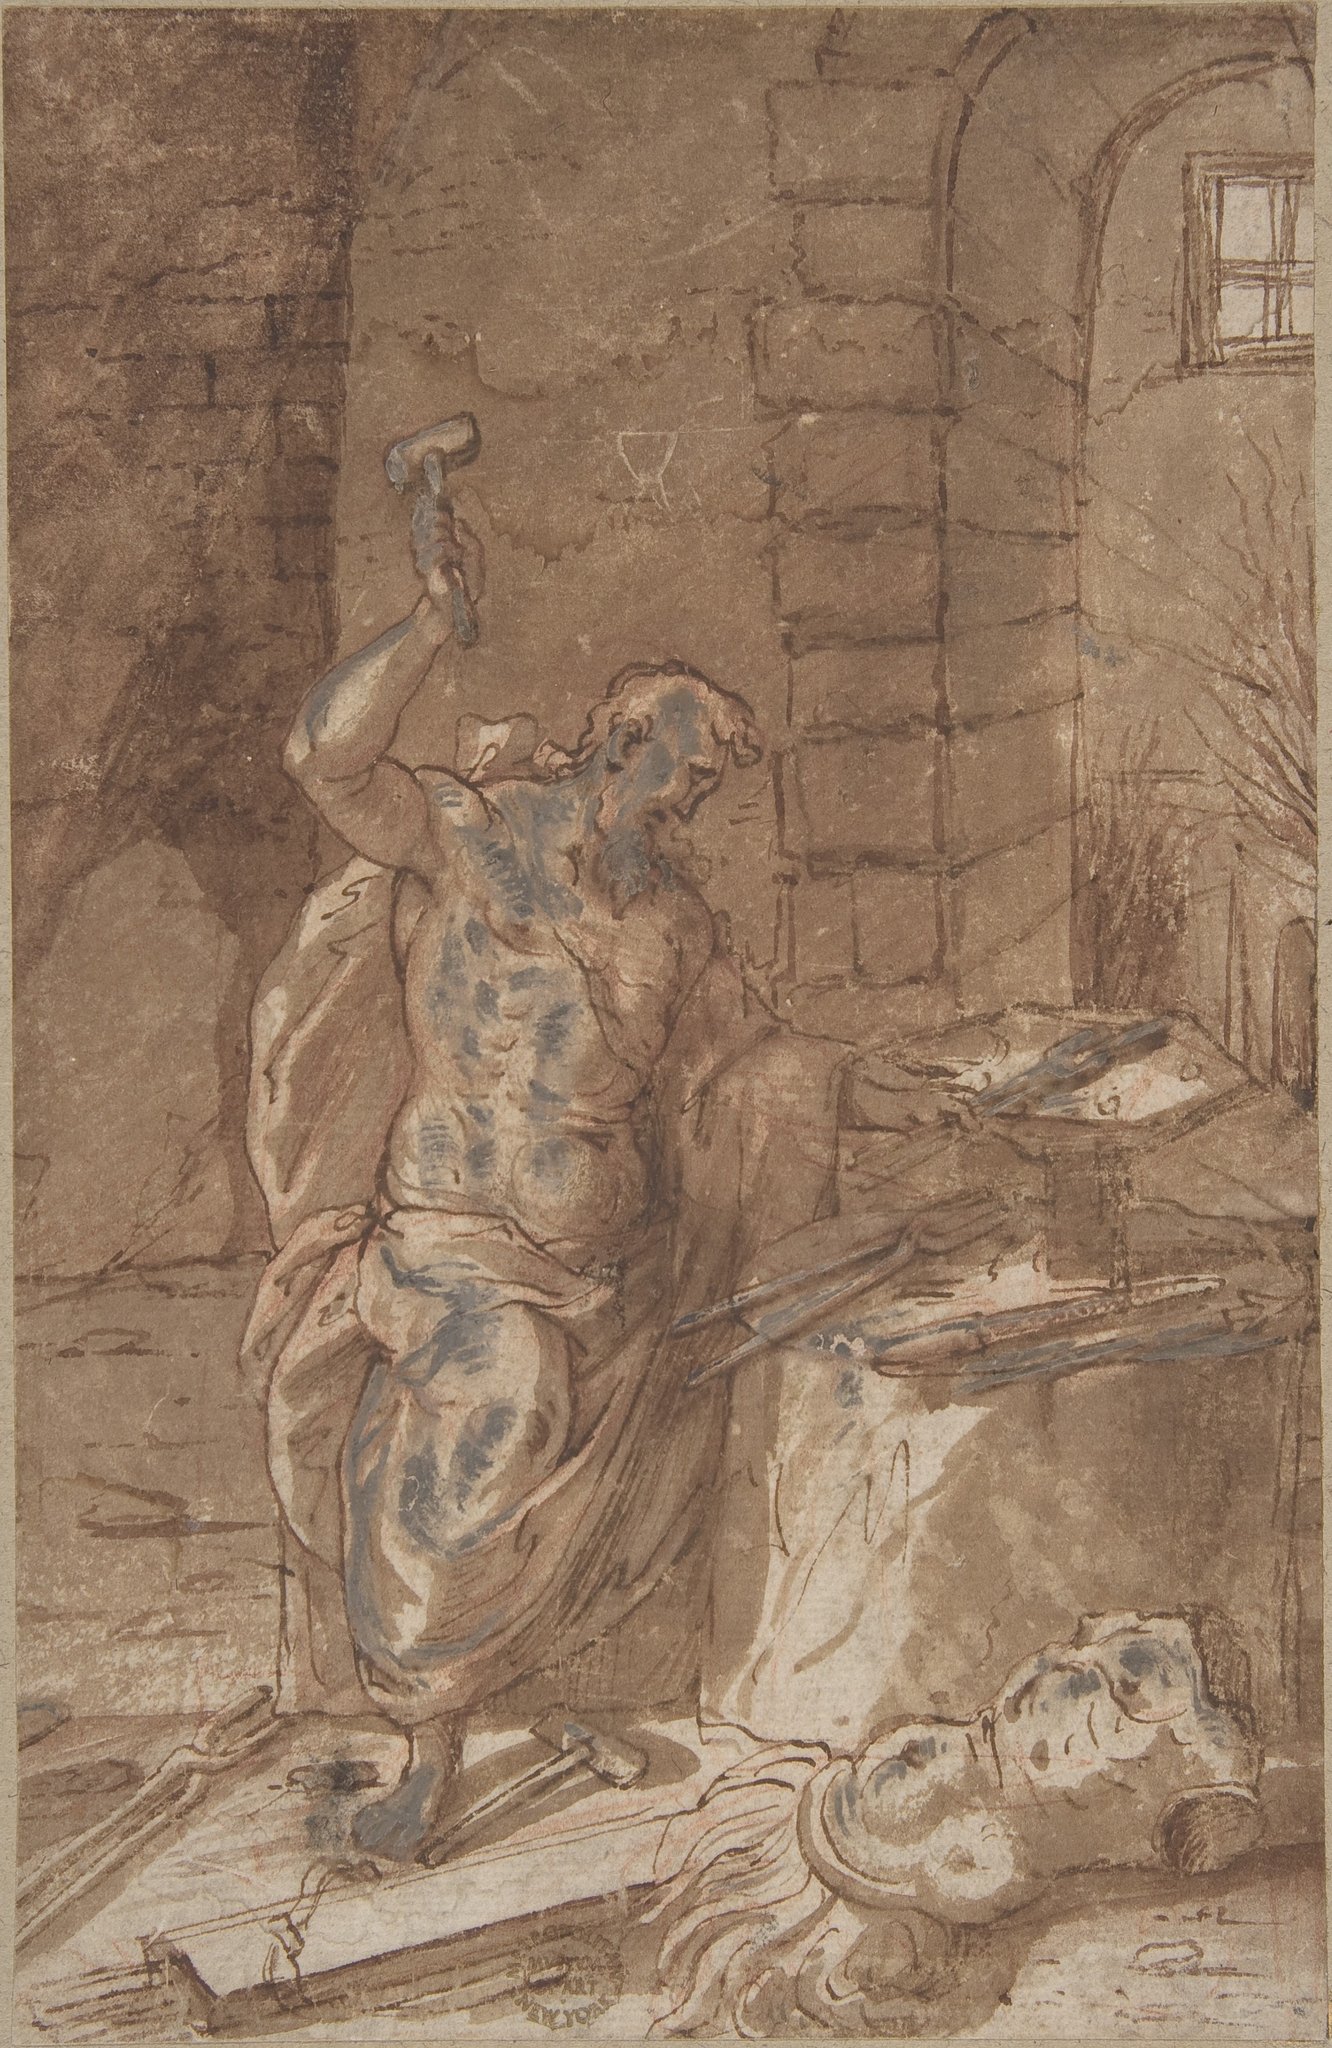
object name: drawing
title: Vulcan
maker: anonymous, italian, roman-bolognese, 17th century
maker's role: artist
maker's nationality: italian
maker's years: 1600-1700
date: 1601-1700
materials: chalk, ink, lead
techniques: brush, highlighting, pen, wash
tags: vulcan,hammers